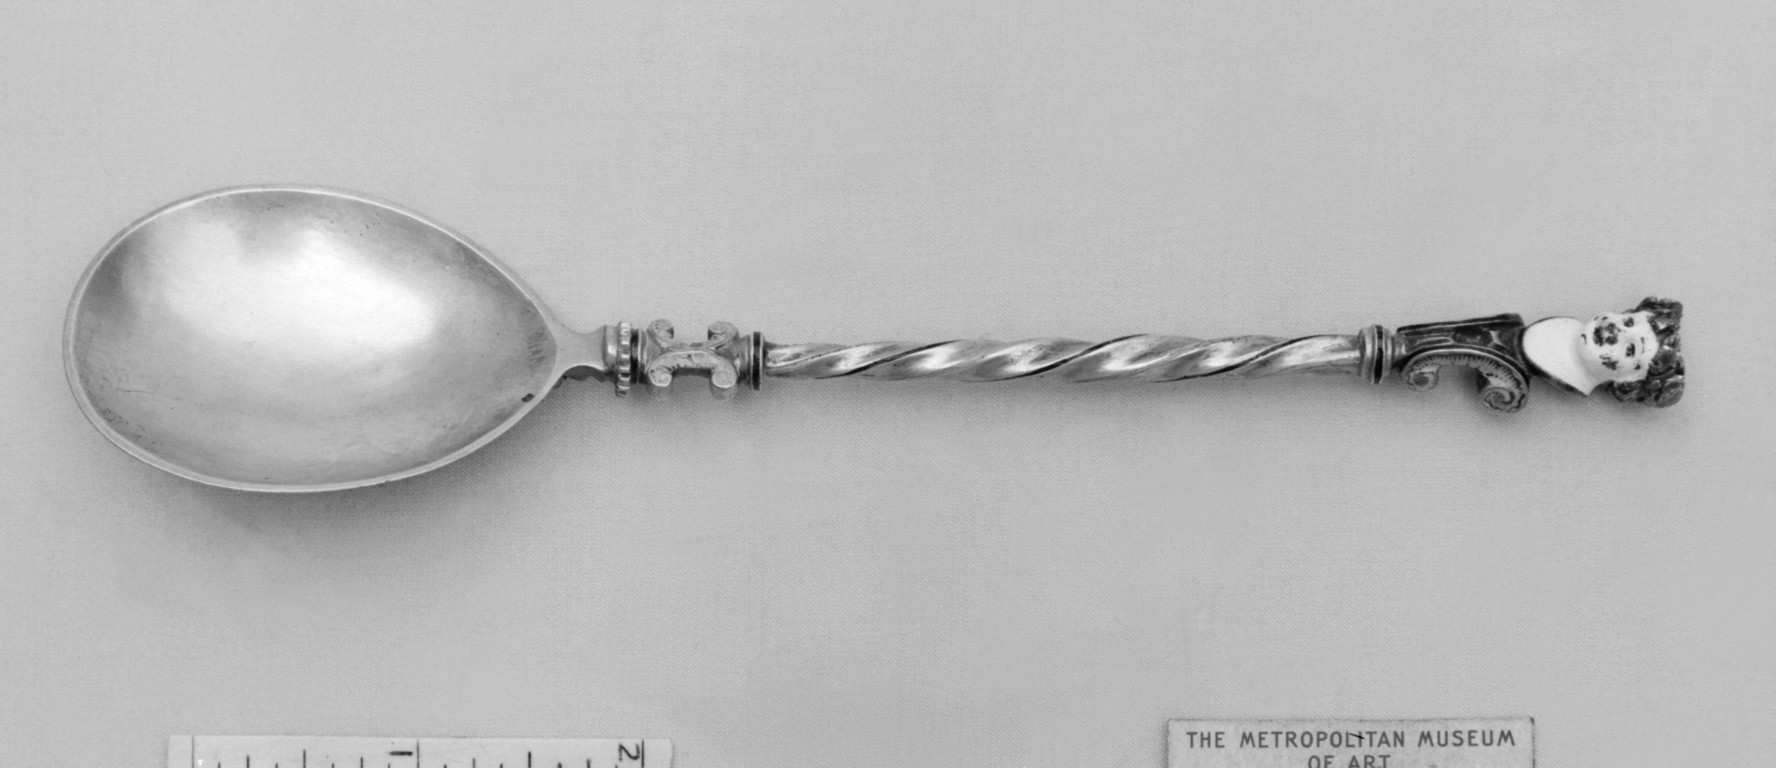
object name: spoon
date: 1601-1700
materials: gilt, silver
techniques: enamel